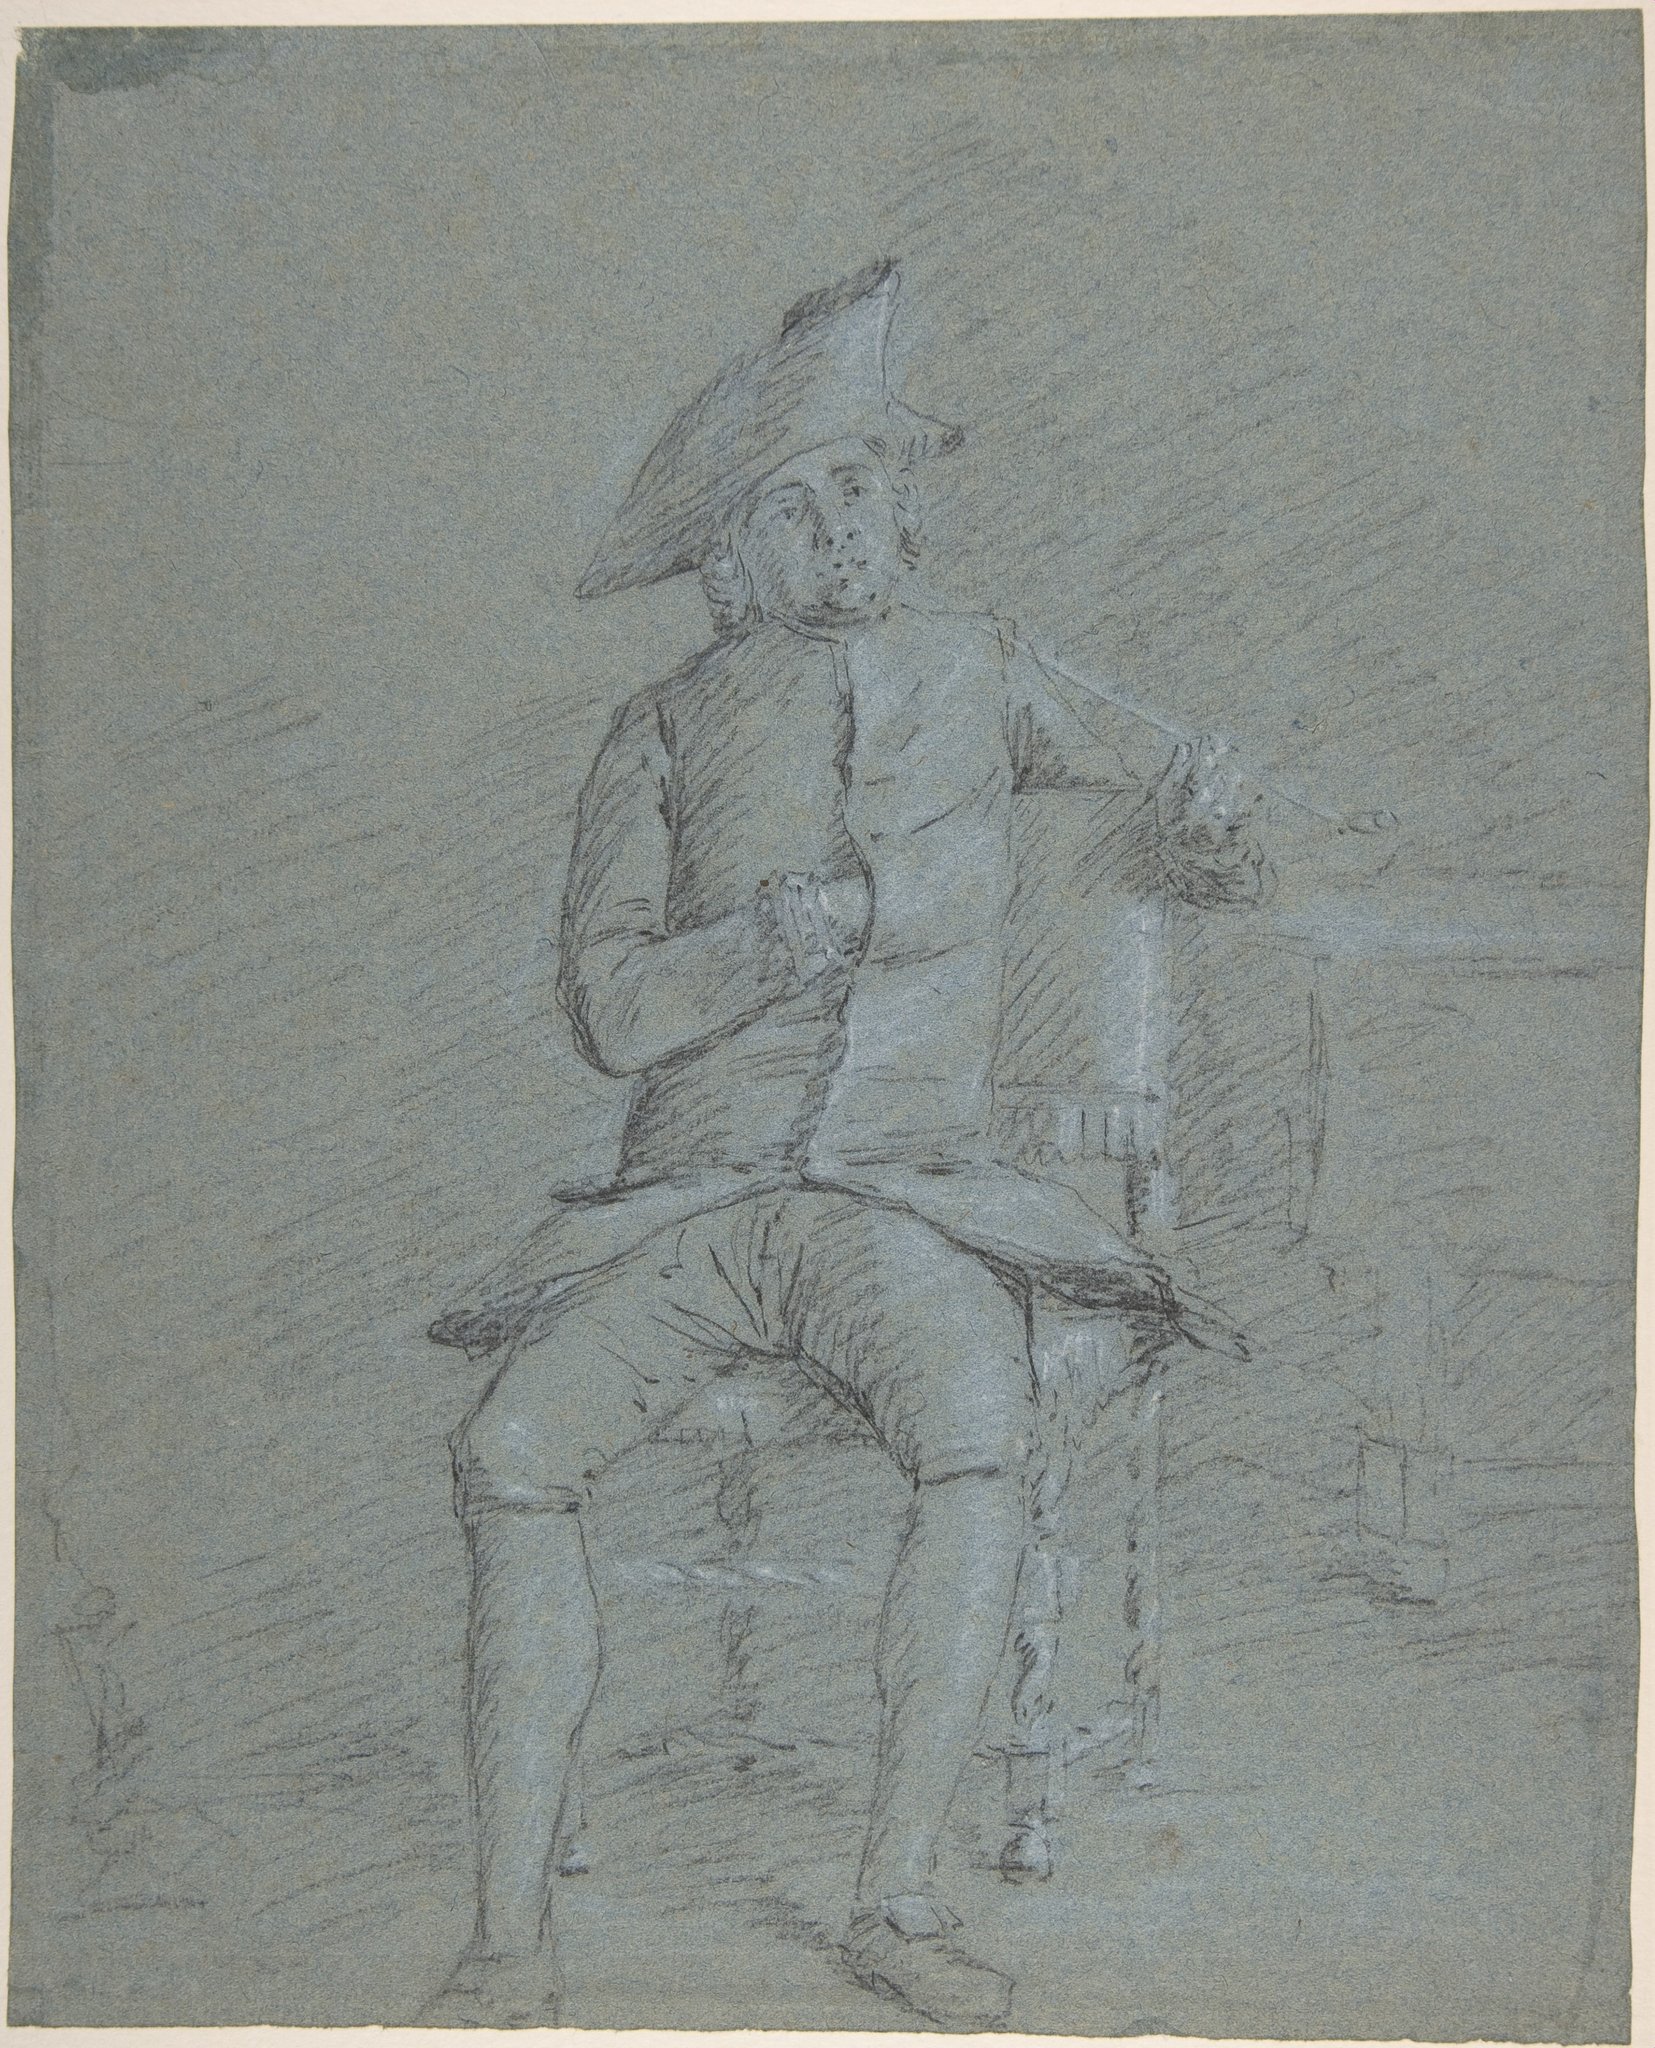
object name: drawing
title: Seated Gentleman Holding a Pipe (recto); Half-Length Study of the Same Man (verso)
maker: francisco bayeu y subias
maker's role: artist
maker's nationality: spanish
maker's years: 1734-1795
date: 1734-1795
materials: chalk, paper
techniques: highlighting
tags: men